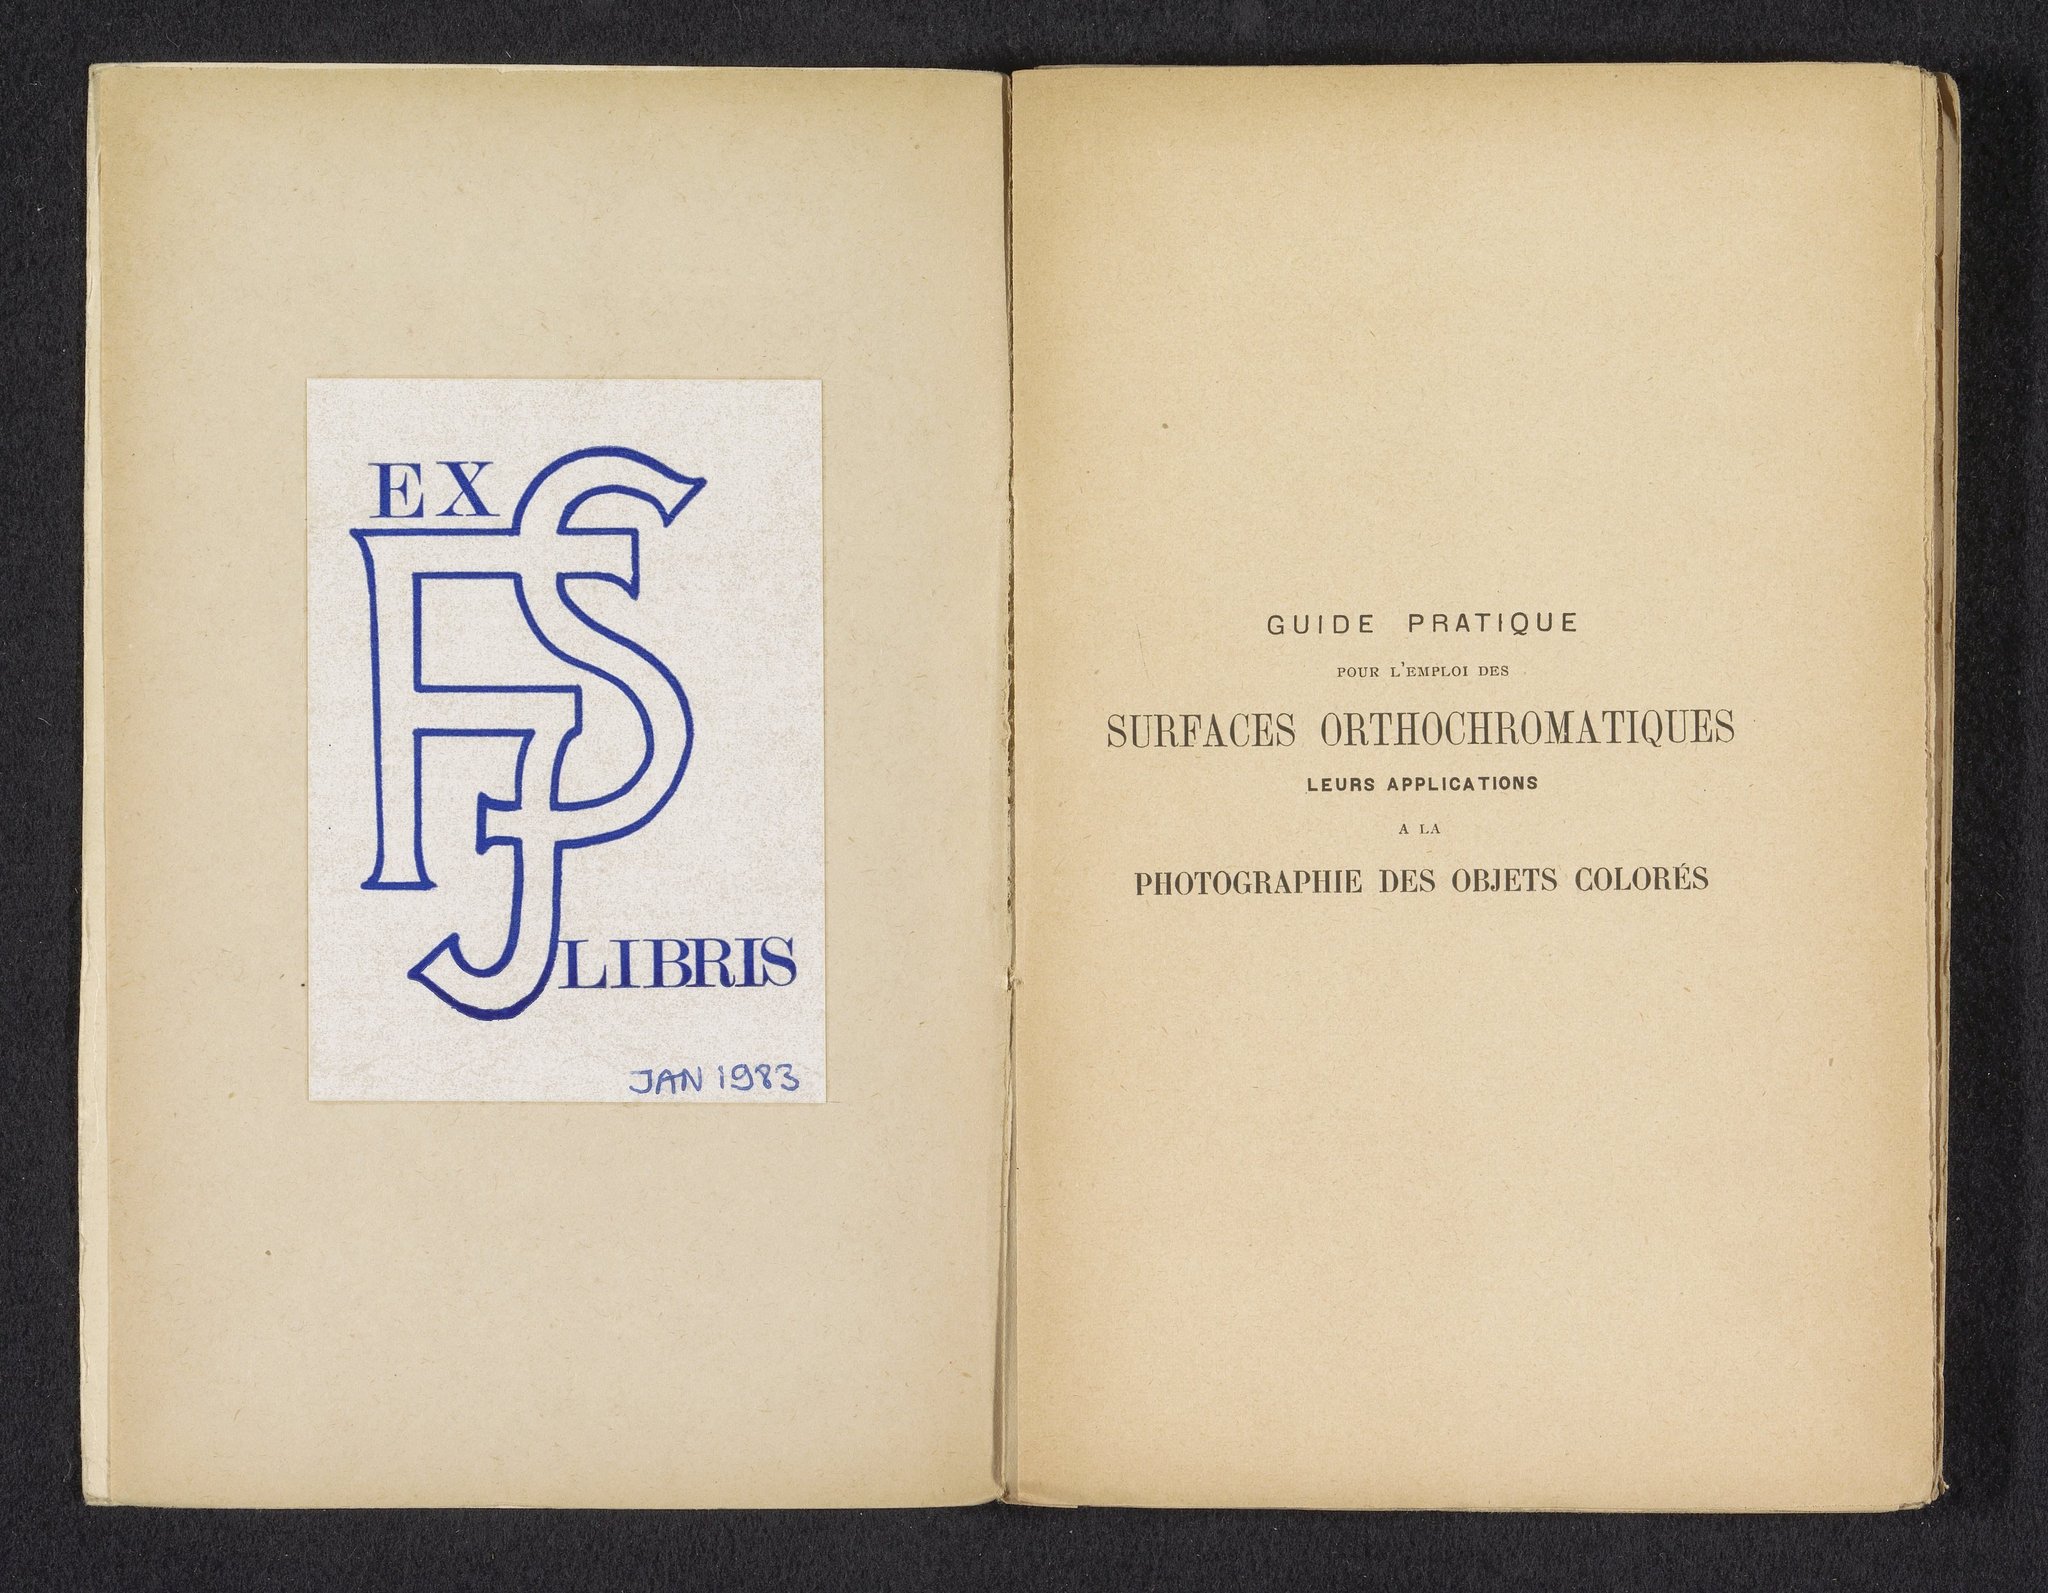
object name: book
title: Guide pratique pour l'emploi des surfaces orthochromatiques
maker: léopold mathet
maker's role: amateurfotograaf, apotheker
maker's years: 1850-1922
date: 1892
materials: paper, photographic support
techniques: albumen print, printing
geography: paris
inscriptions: inscription: ‘ex libris SFJ’